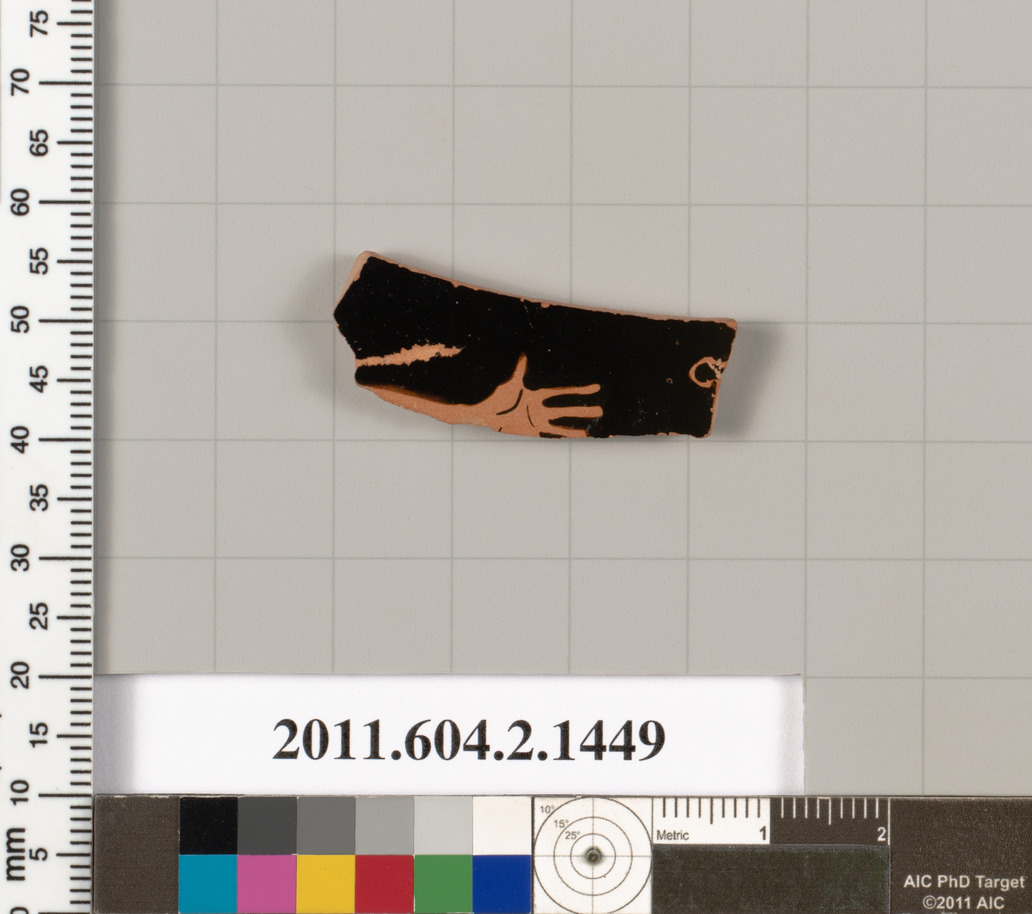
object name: skyphos fragment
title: Terracotta fragment of a skyphos (deep drinking cup)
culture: greek, attic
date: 490-470 BCE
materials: terracotta